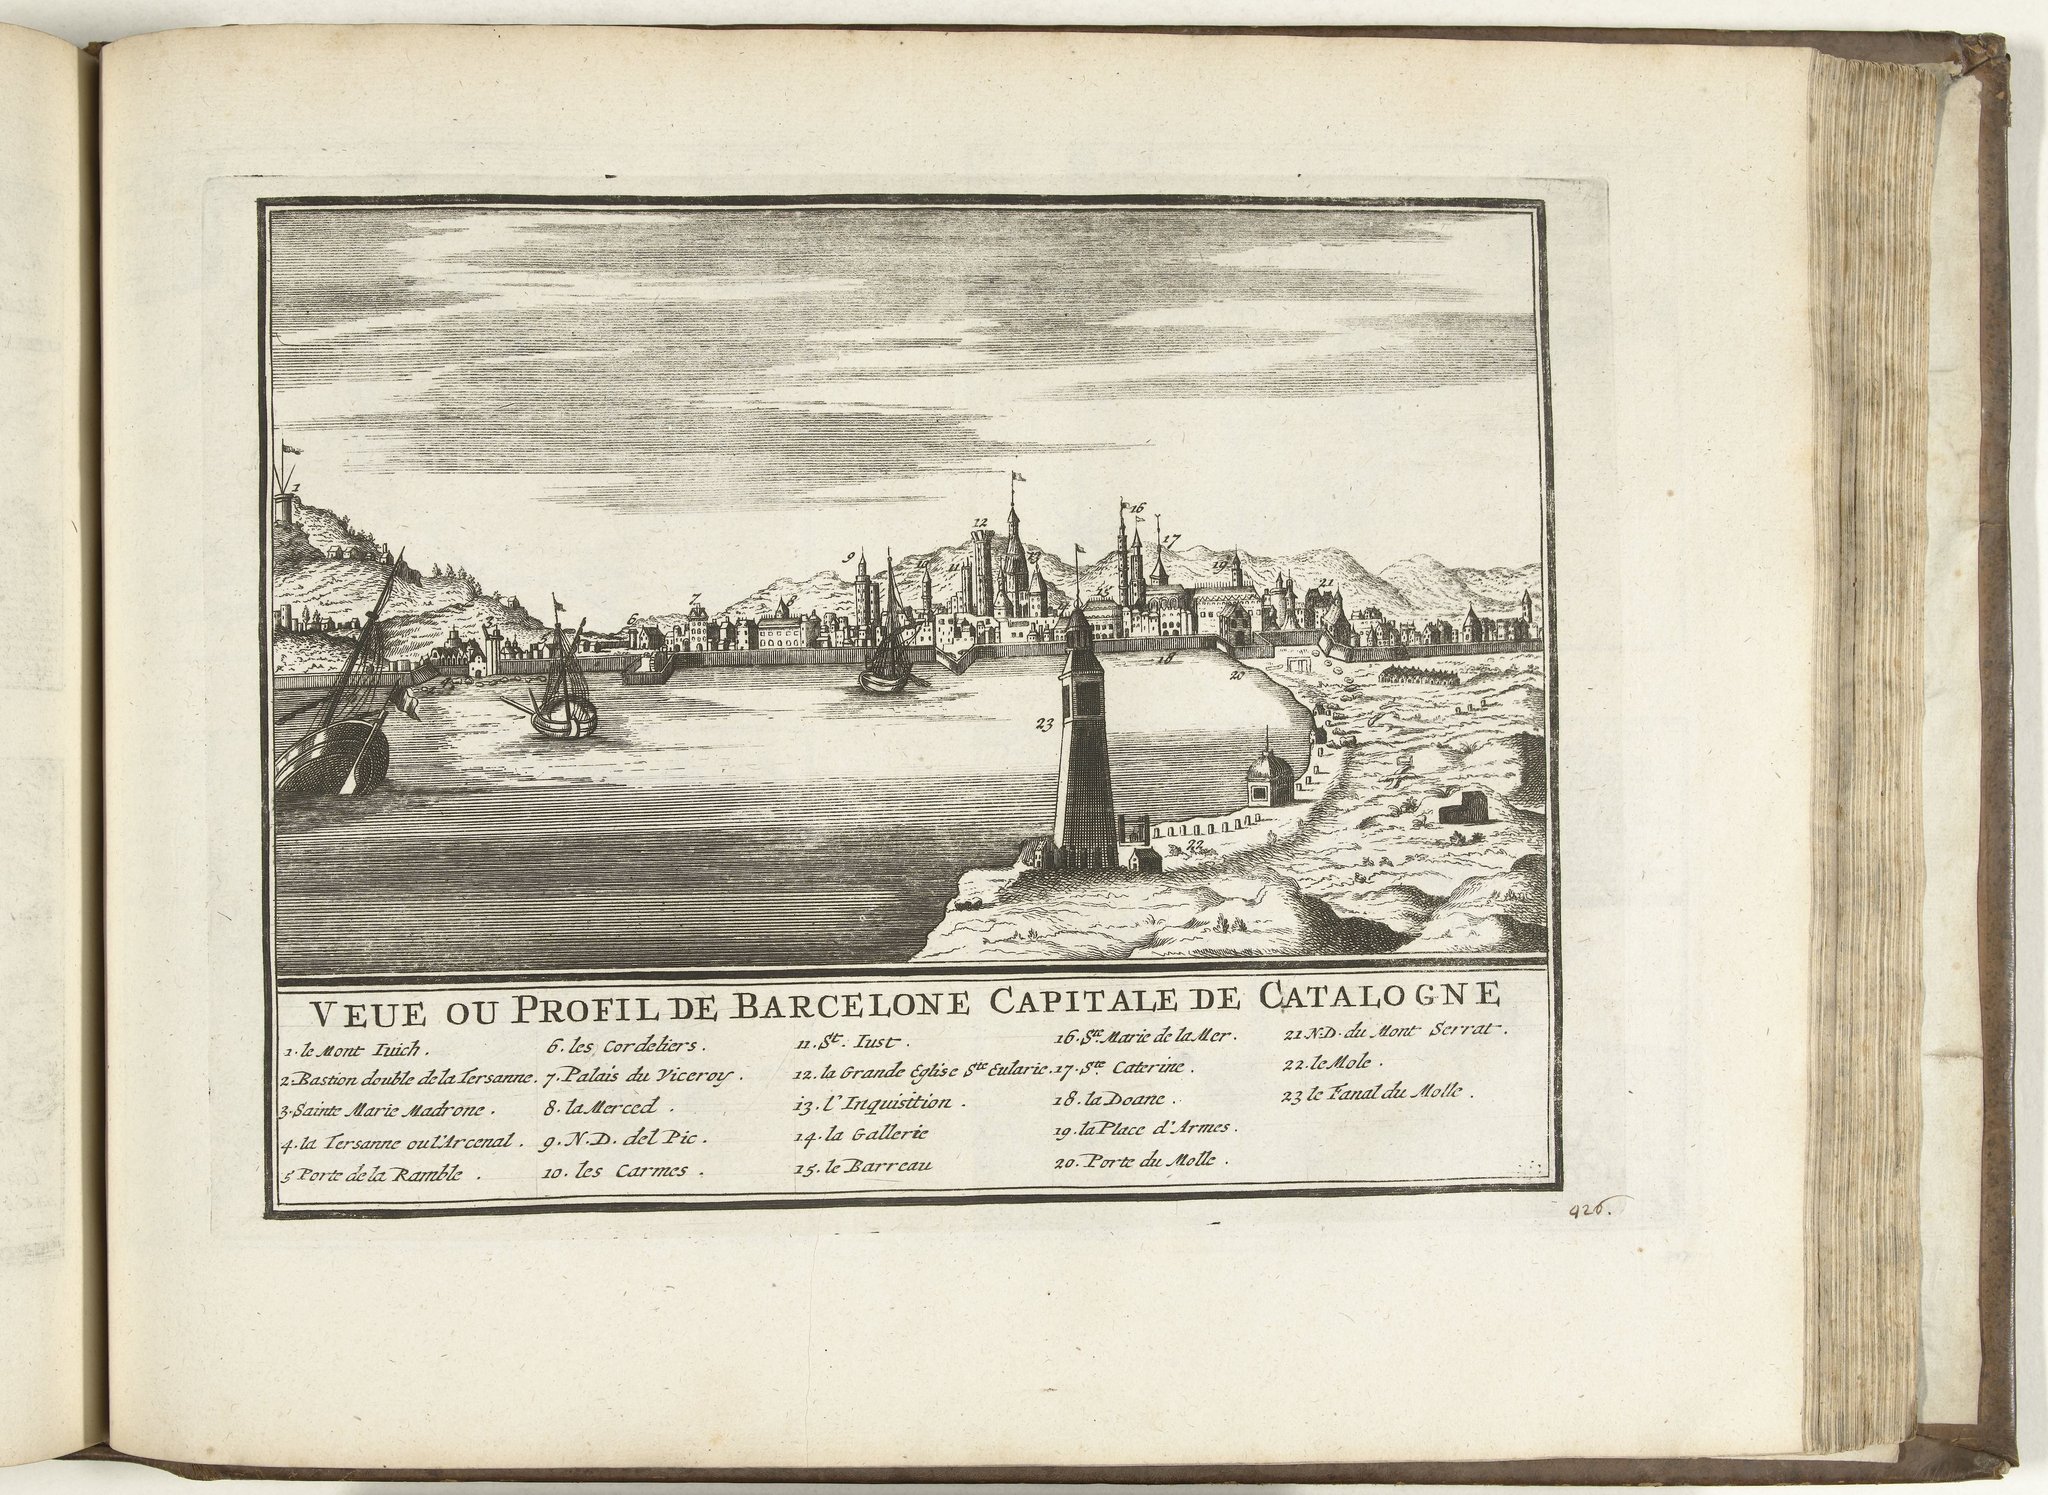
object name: print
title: Les Forces de l'Europe, Asie, Afrique et Amerique (...) Comme aussi les Cartes des Côtes de France et d'Espagne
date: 1726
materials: paper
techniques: etching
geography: leiden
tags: barcelona, spaanse successieoorlog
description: Gezicht op de Spaanse stad Barcelona. Plaat nr. 426 in deel XVII van het prentwerk: Les Forces de l'Europe, Asie, Afrique et Amerique ... Comme aussi les Cartes des Côtes de France et d'Espagne uit 1726, dit tweede deel met 271 met de hand genummerde platen van vermaarde sterke steden en vestingen in het kader van de Spaanse Successieoorlog 1701-1713. Voor het merendeel zijn deze platen gekopieerd naar de anonieme Franse platen van vermaarde sterke steden en vestingen: in Les forces de l'Europe en in: Le theatre de la guerre, dans les Pays-Bas, beide oorspronkelijk uitgegeven door Nicolas de Fer te Parijs (1693-1697) in het kader van de Negenjarige Oorlog. Titel en opschriften in het Frans. Rechtsonder sporen van het weggepolijste nummer: 262.